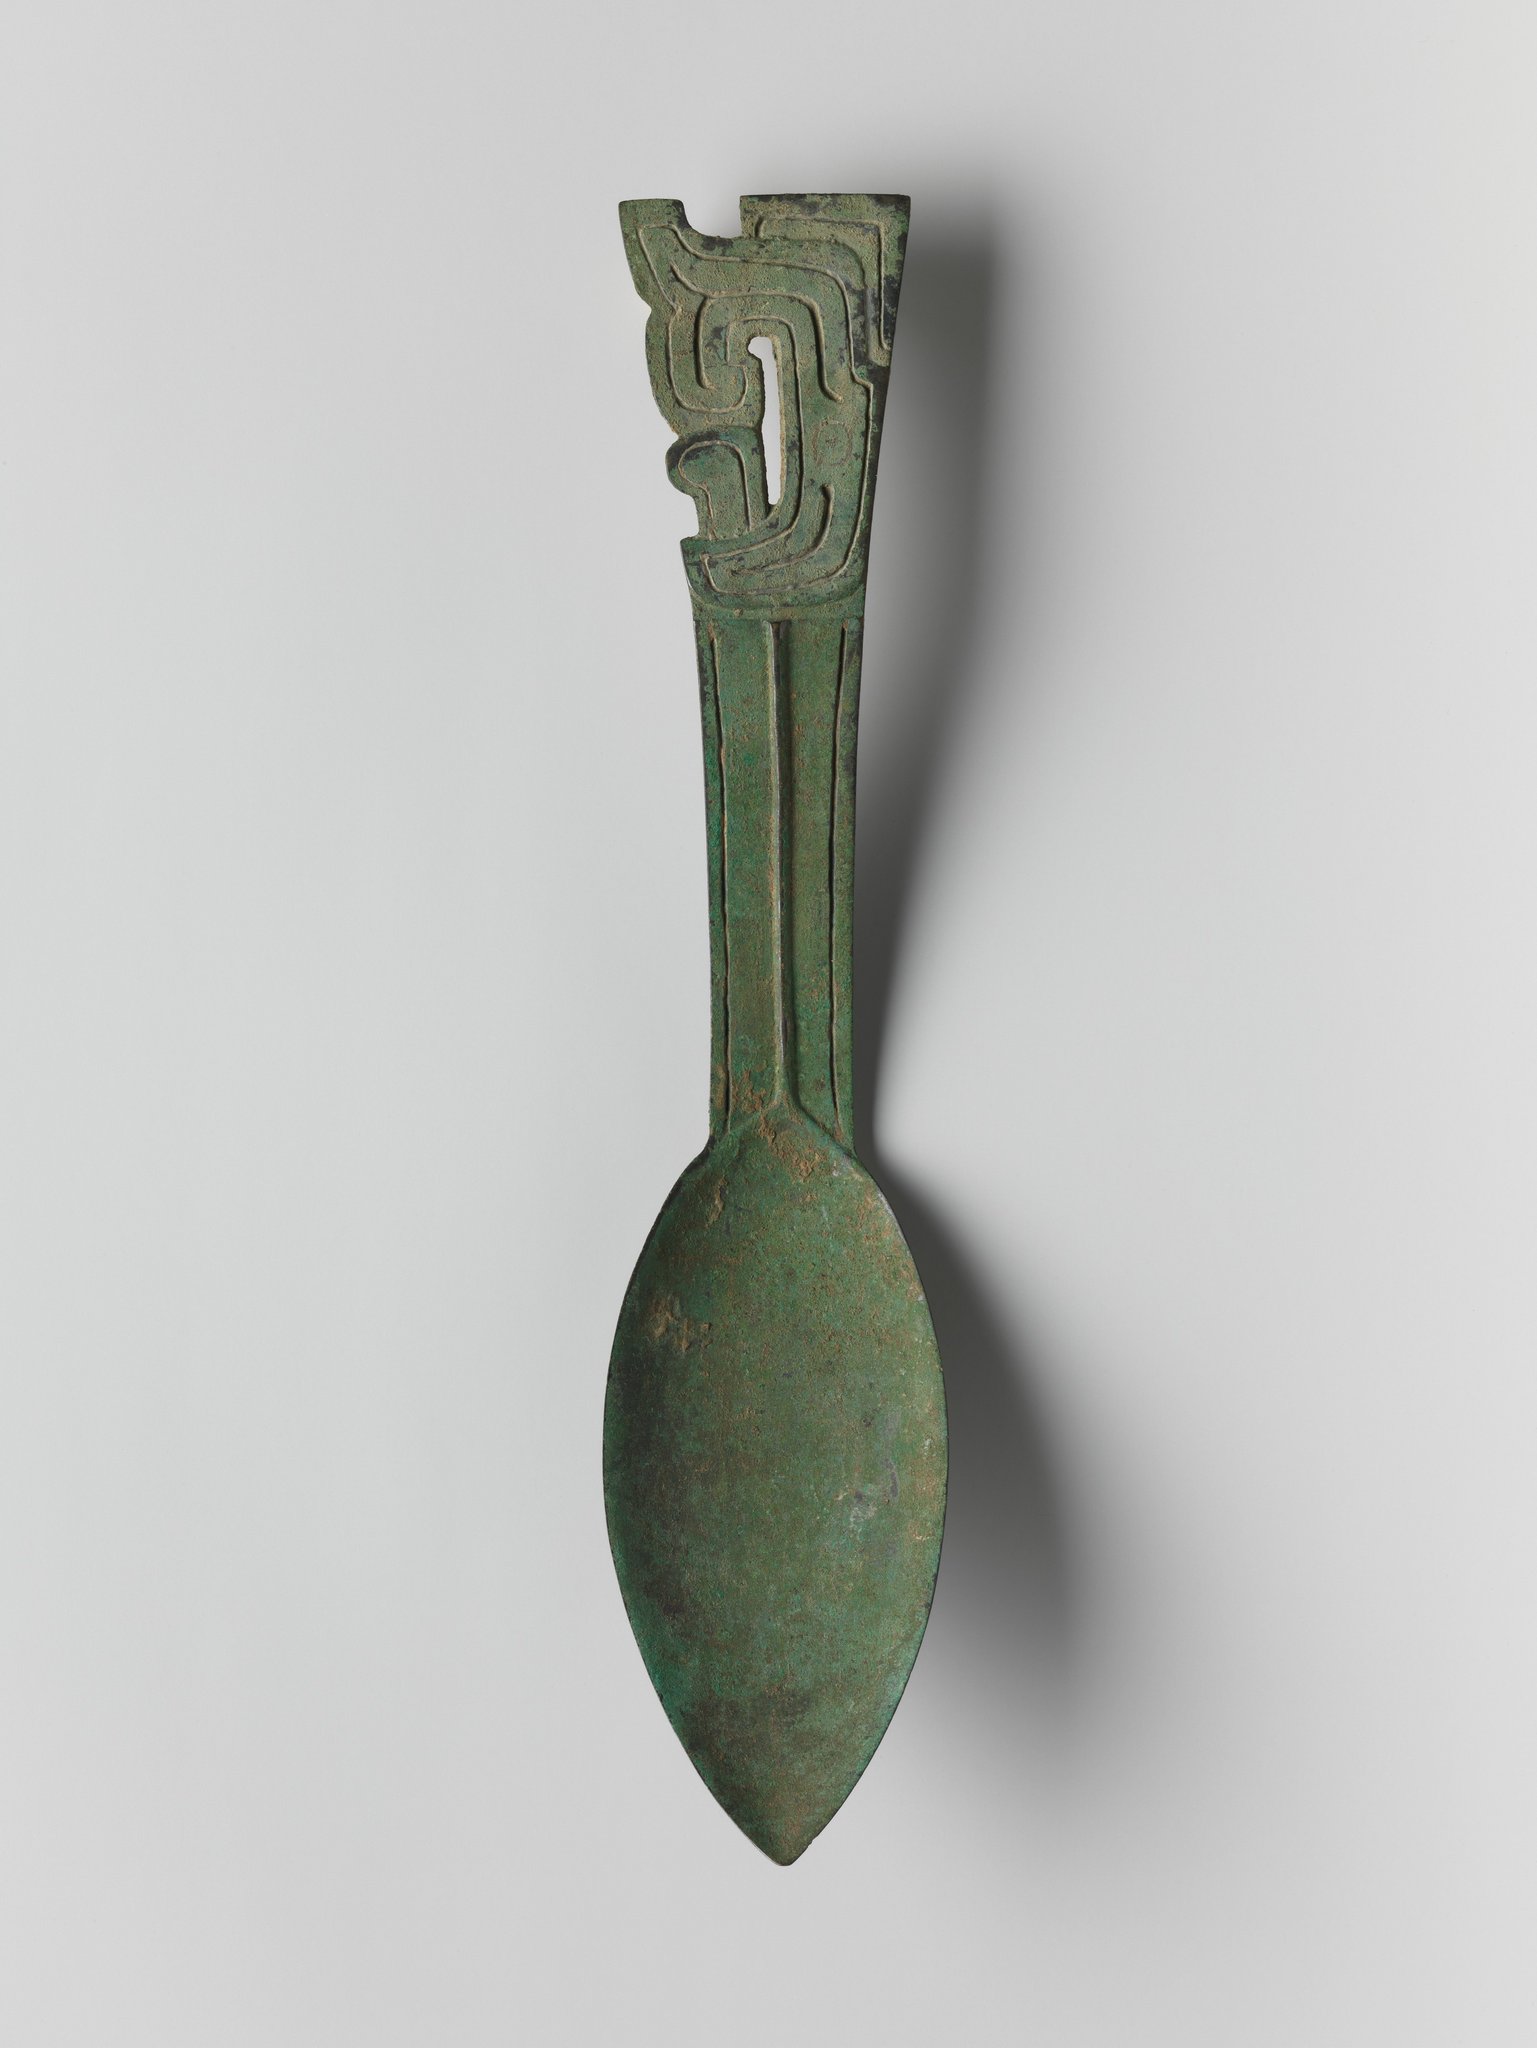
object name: spoon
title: Ritual Spoon (Bi)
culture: chinese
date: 834-768 BCE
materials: bronze